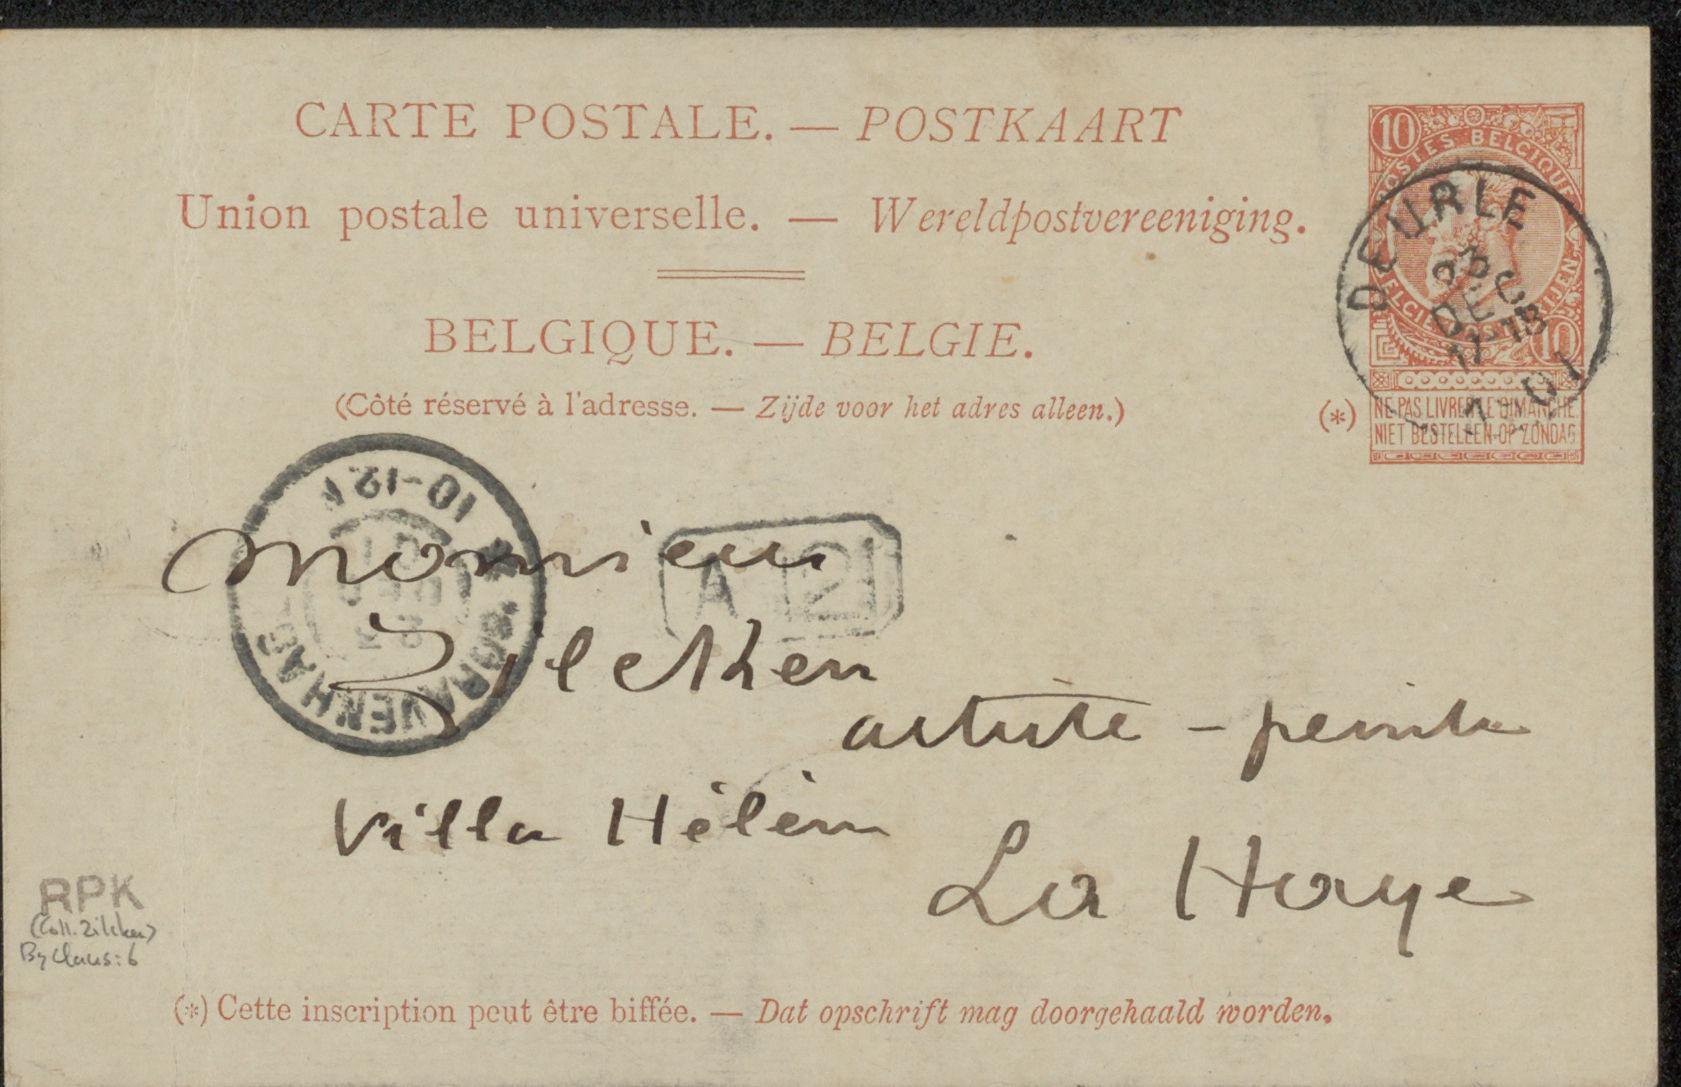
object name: postcard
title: Briefkaart aan Philip Zilcken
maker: emile claus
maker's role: print maker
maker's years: 1849-1924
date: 1901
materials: cardboard, ink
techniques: pen, writing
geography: astène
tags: the hague, painter, draughtsman, philip zilcken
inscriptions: collector's mark: ‘RPK’